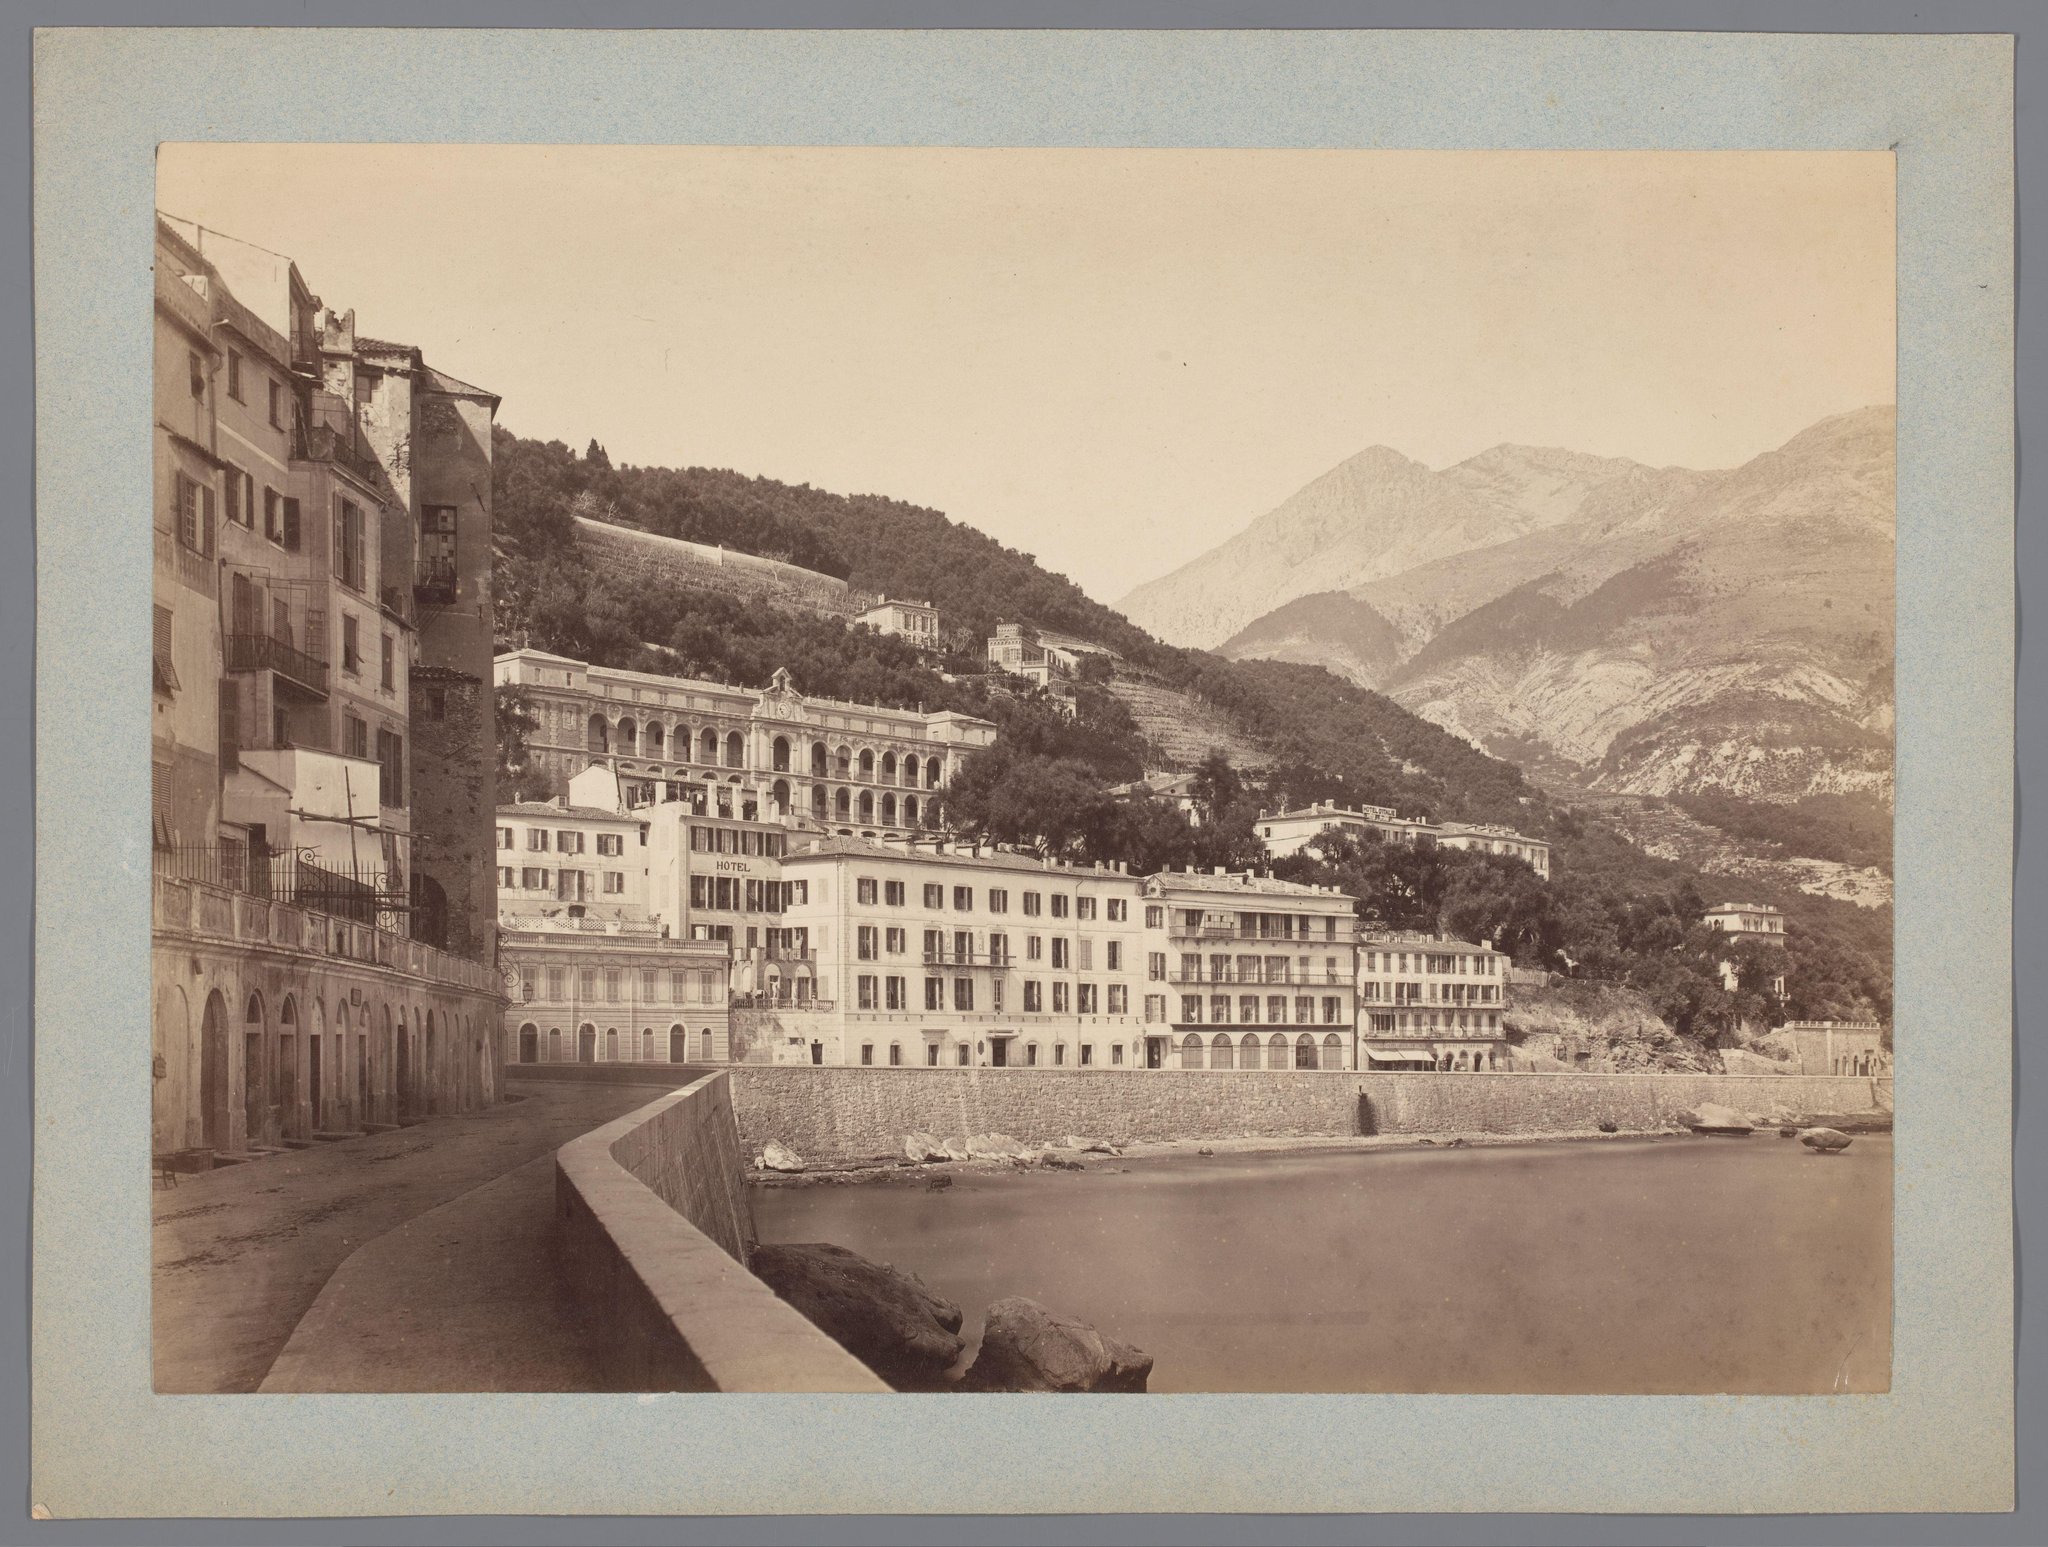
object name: photograph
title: Gezicht op de kustlijn van een stad, met huizen en een kade, Italië [?]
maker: Anonymous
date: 1875-1900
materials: cardboard, paper, photographic support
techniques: albumen print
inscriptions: number: ‘1888’